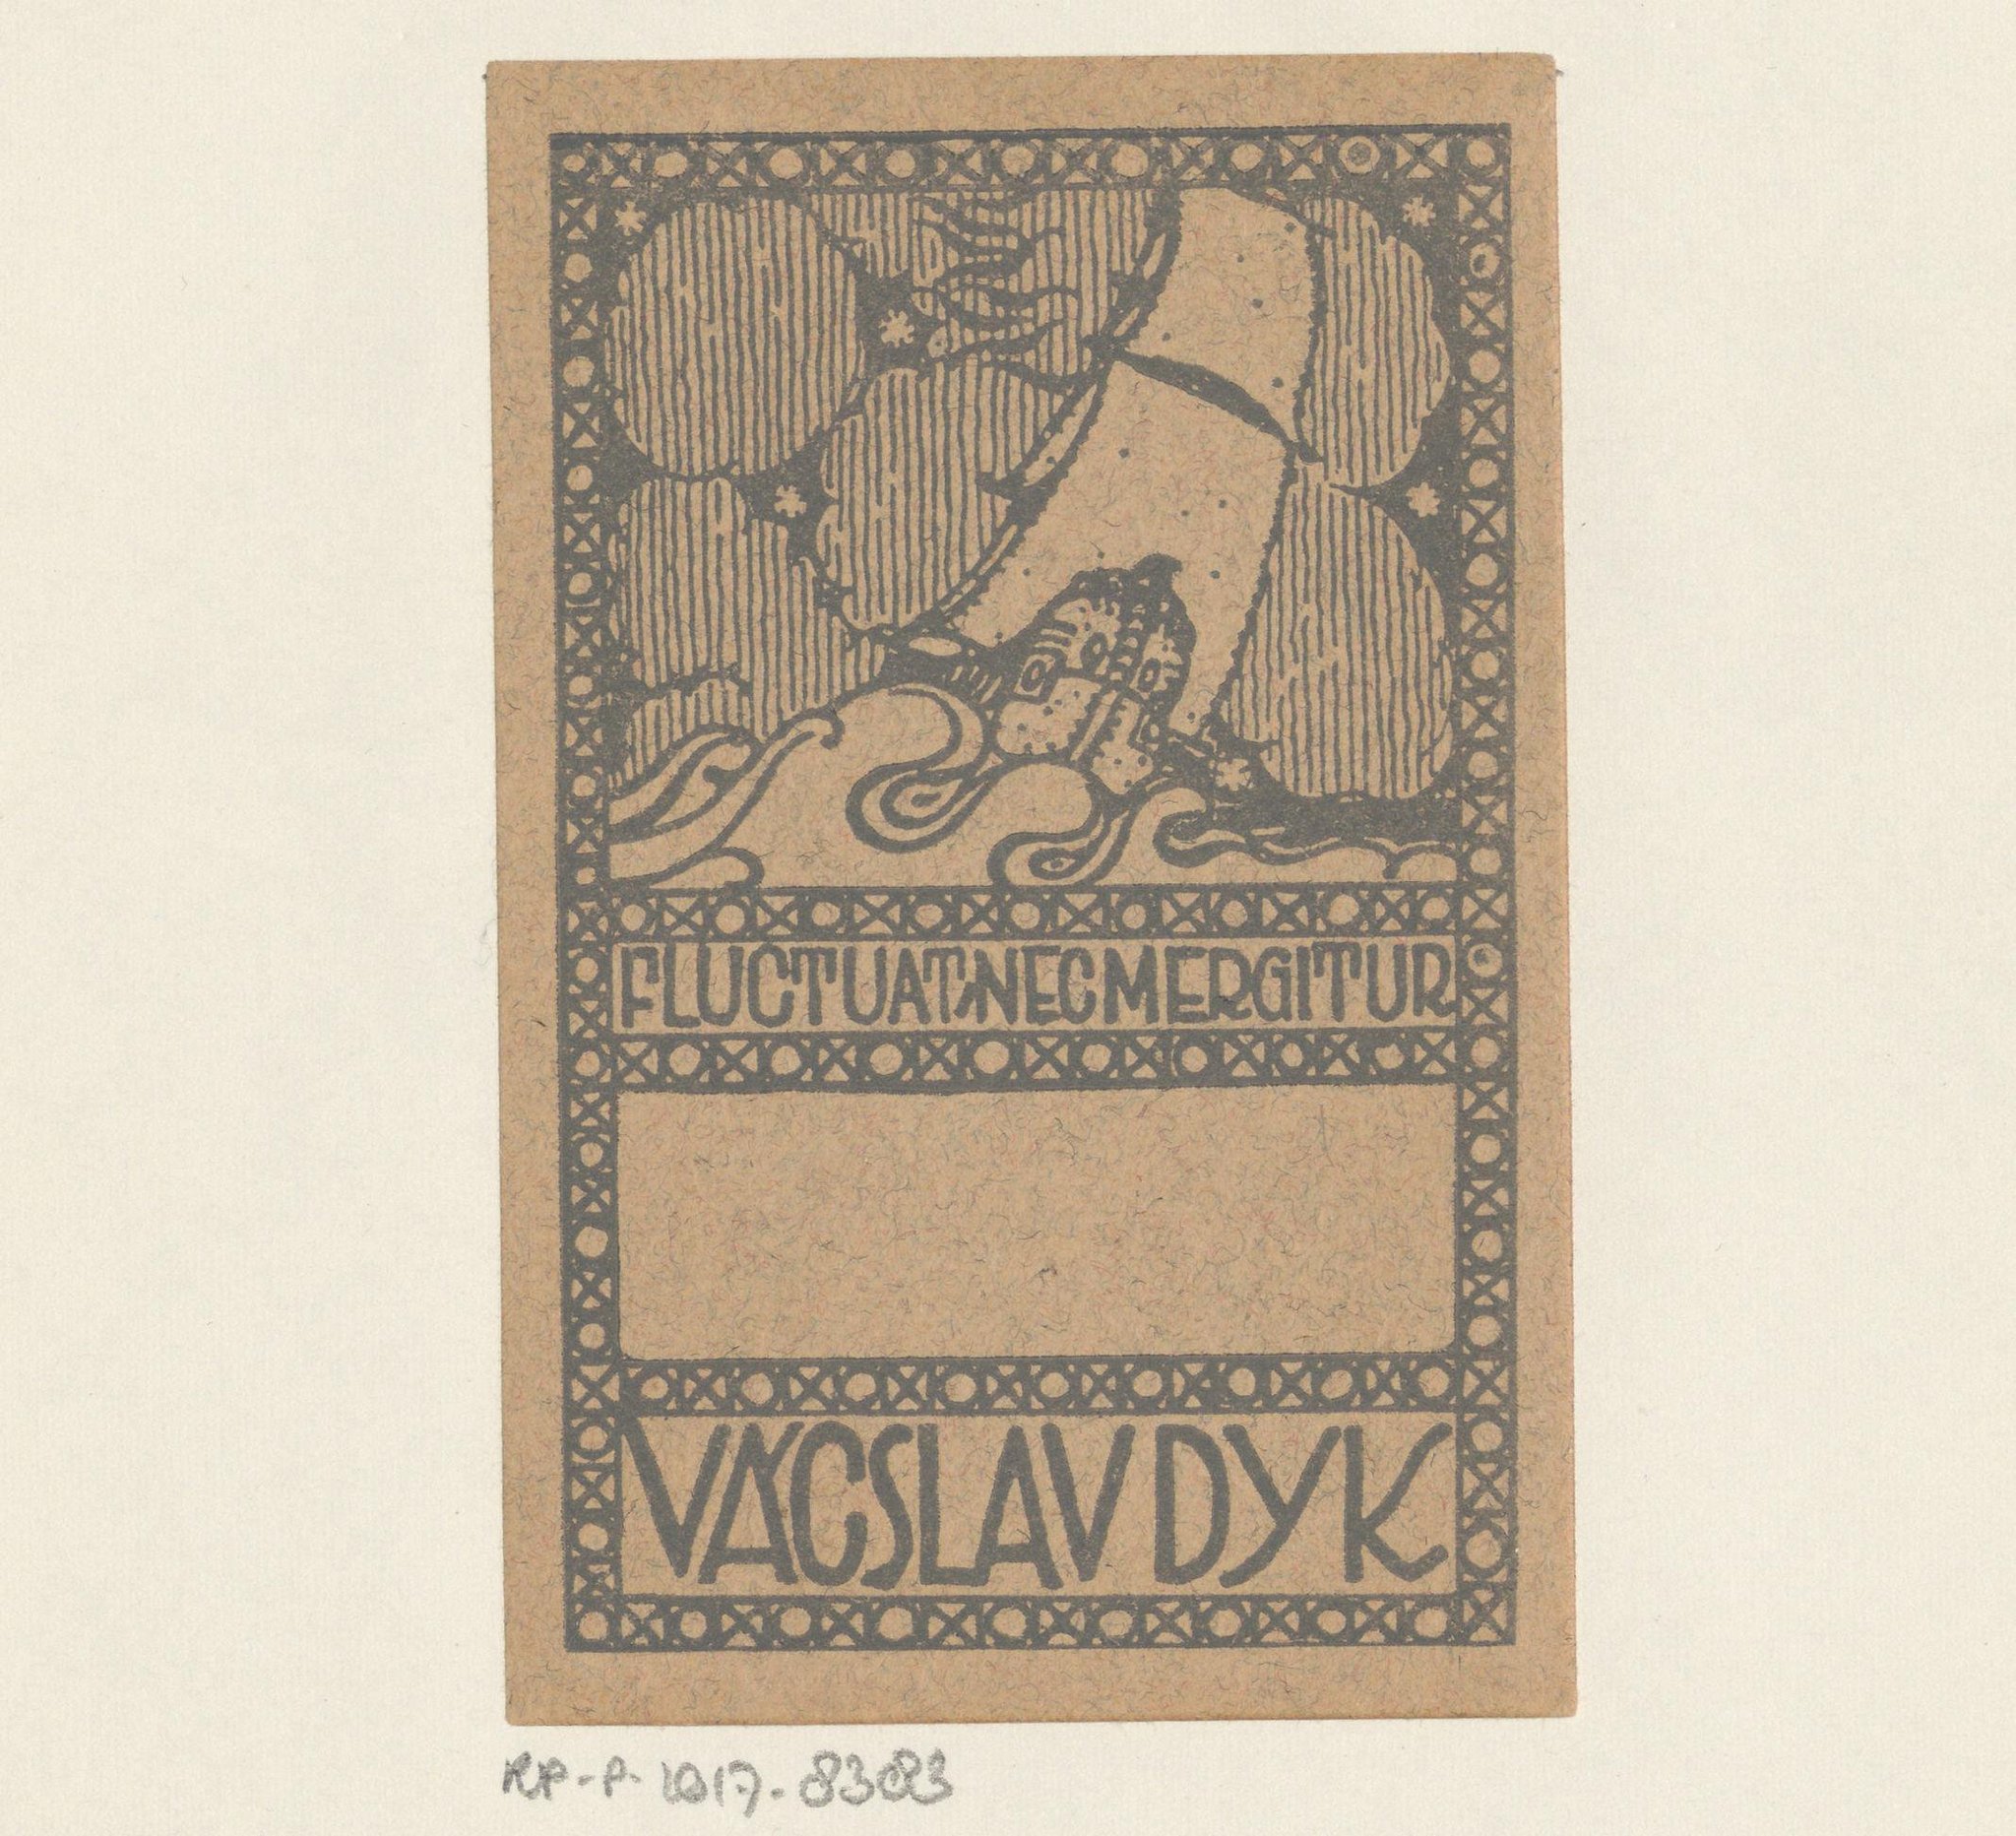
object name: bookplate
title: Ex libris van Václav Dyk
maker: Anonymous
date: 1908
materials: paper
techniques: printing block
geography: czech republic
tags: sailing-ship, sailing-boat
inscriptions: inscription: ‘Jan Konupek/ 1908’